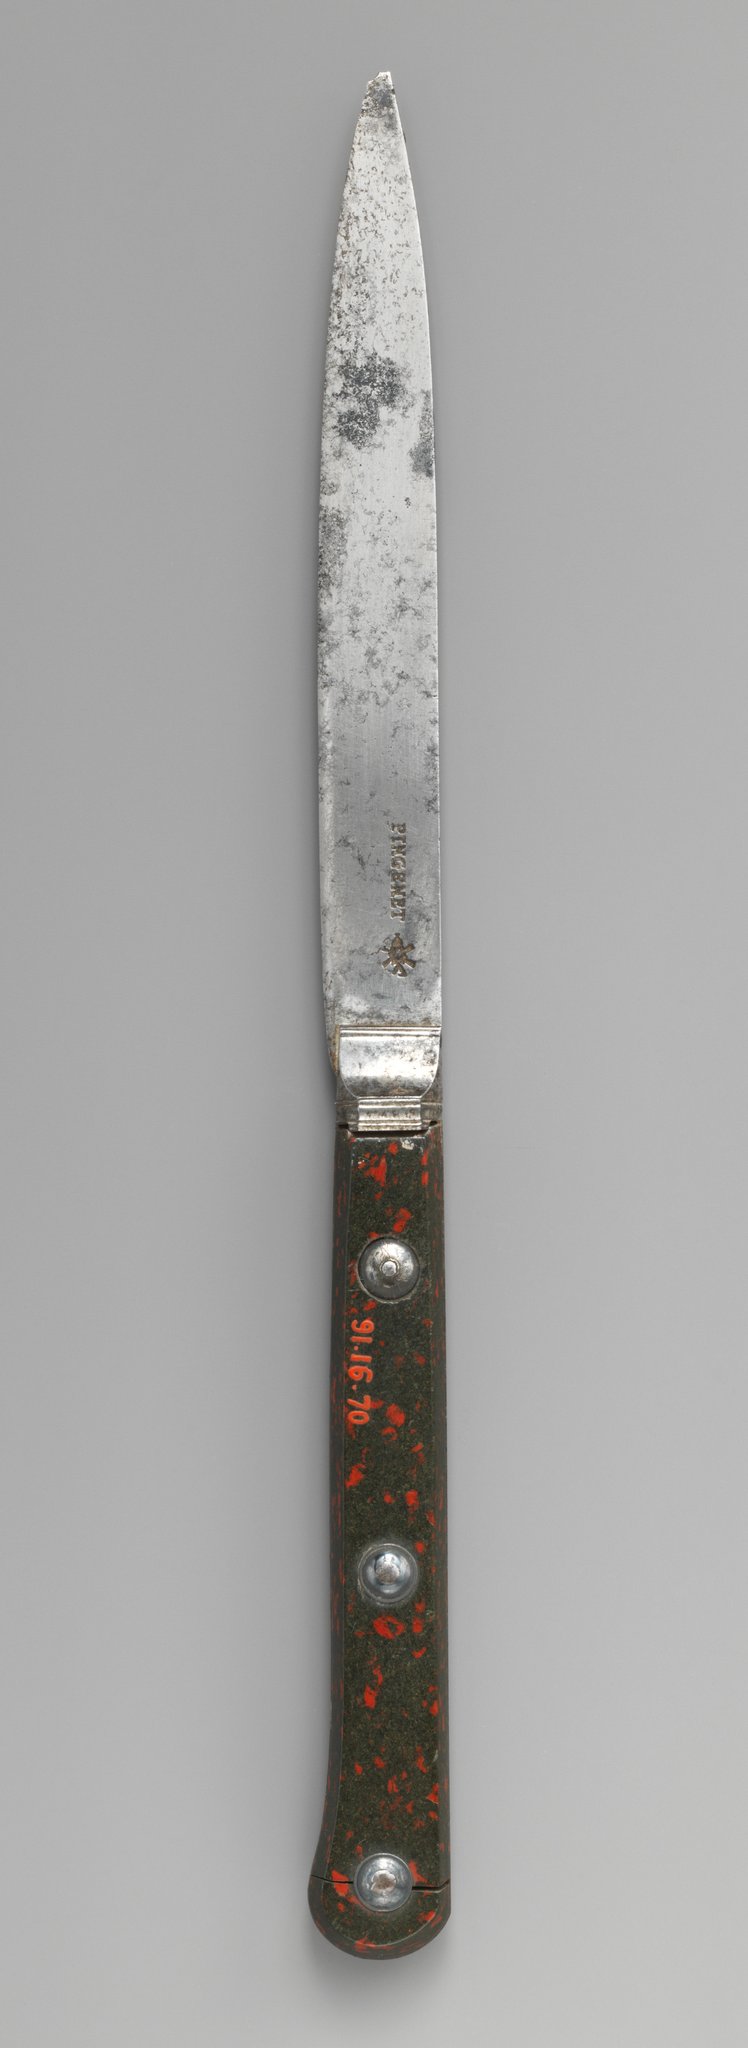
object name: table knife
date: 1801-1900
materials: steel